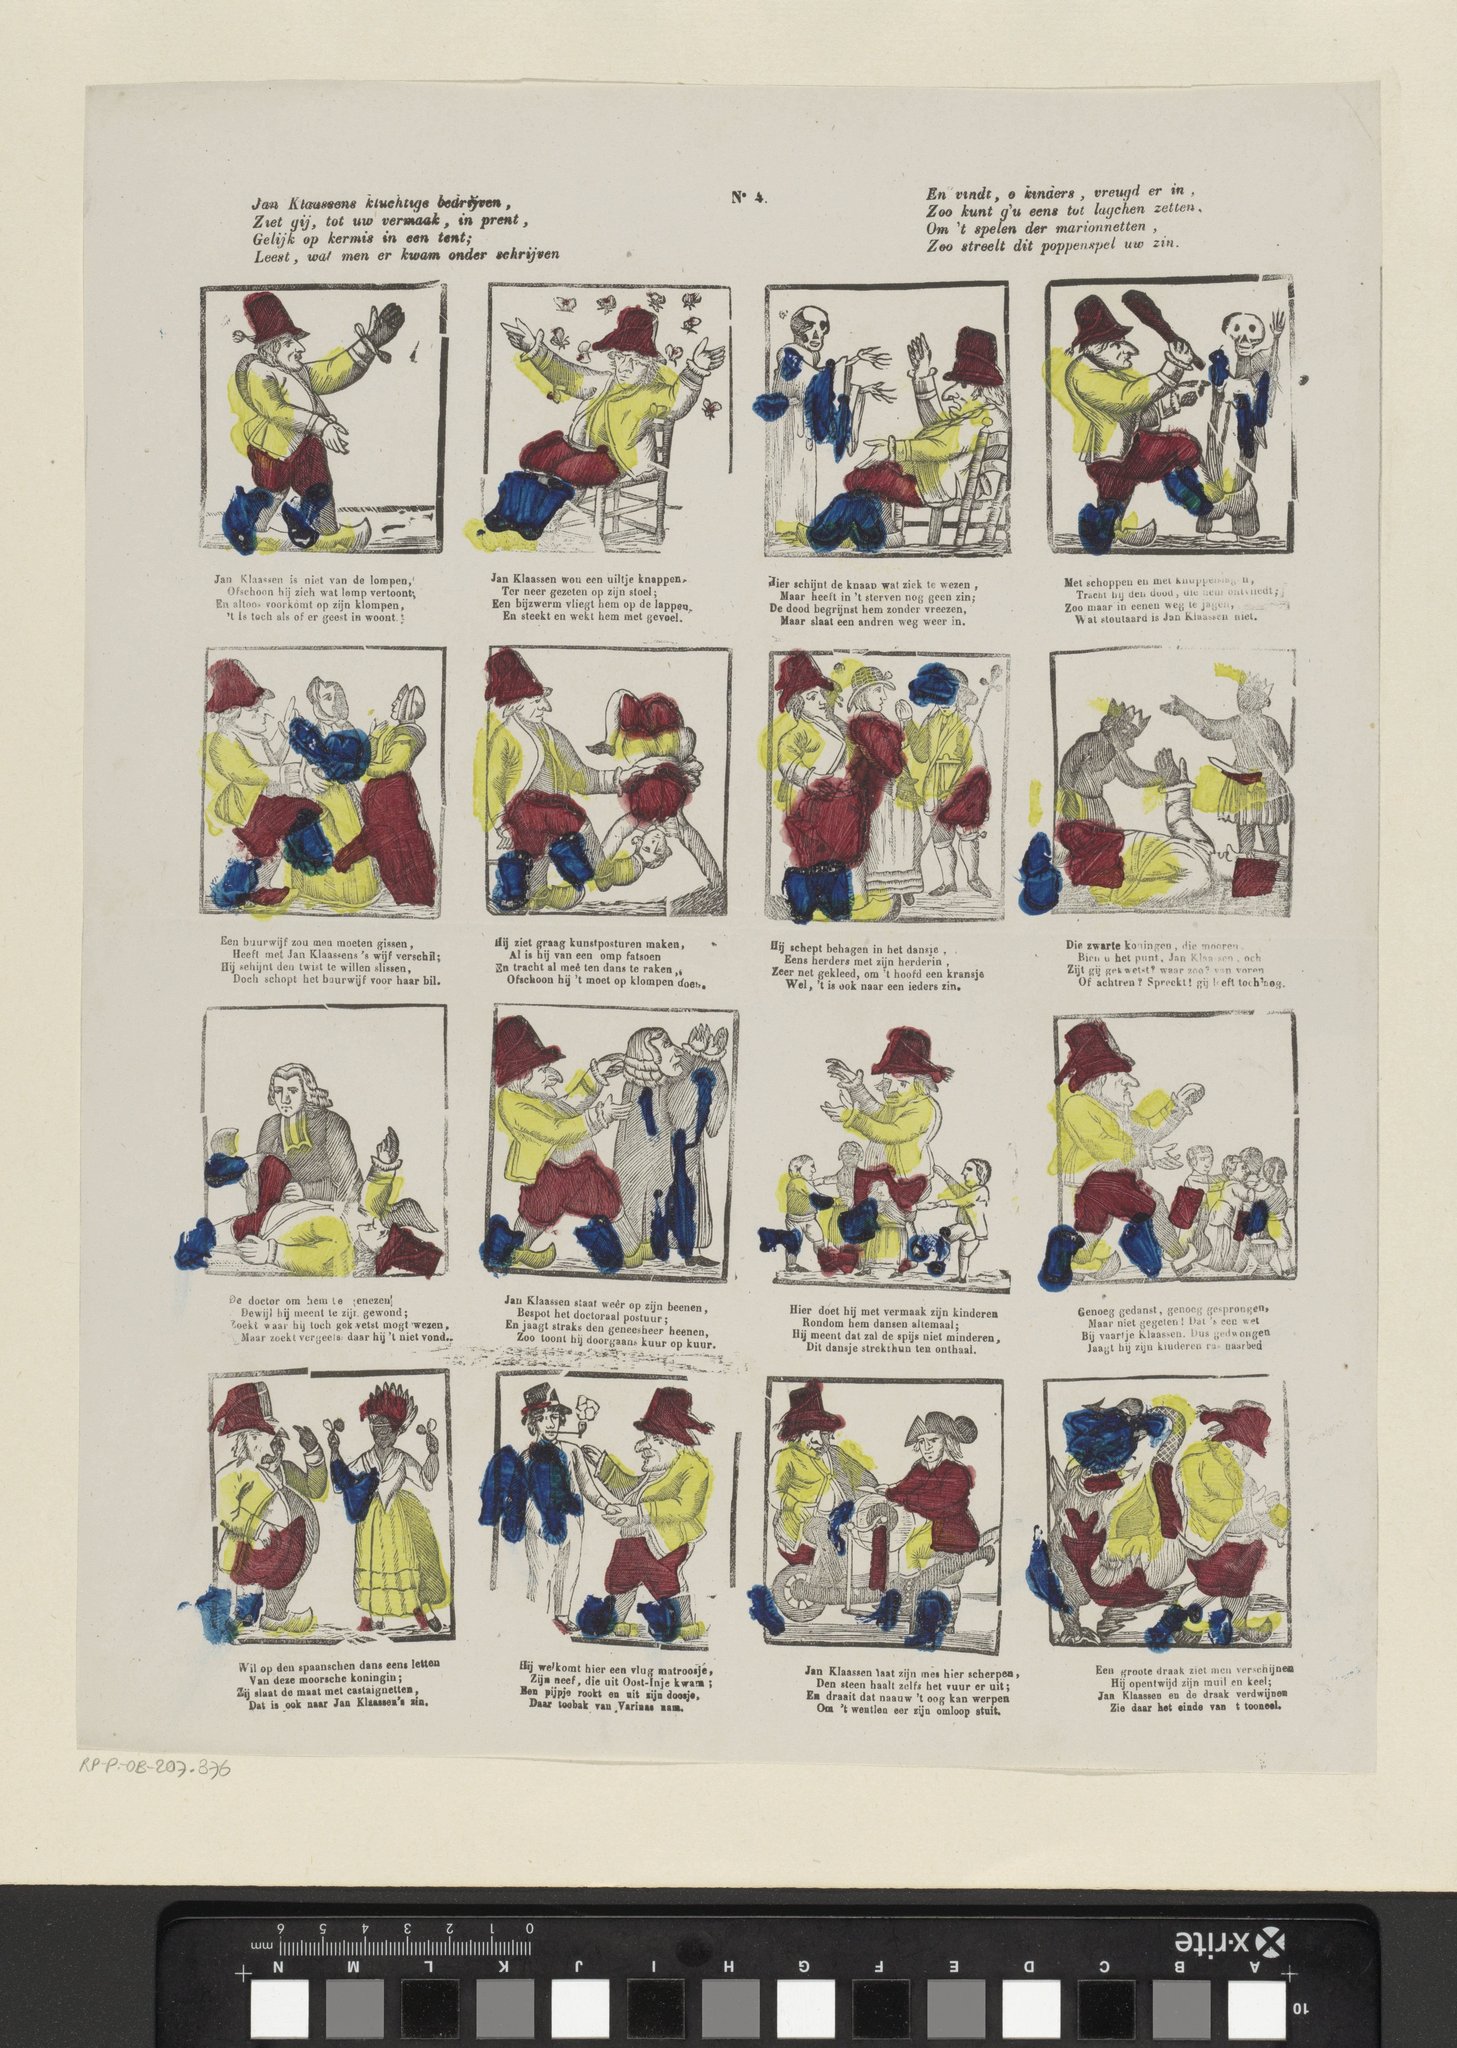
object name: print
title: Jan Klaassens kluchtige bedrijven, / Ziet gij, tot uw vermaak, in prent [(...)]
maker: Anonymous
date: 1848-1881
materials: paper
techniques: colour, letterpress printing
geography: den bosch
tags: punch and judy, tales and fairy tales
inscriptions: collector's mark: Lugt 2760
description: Blad met 16 voorstellingen over het leven van Jan Klaassen. Onder elke afbeelding een vierregelig vers. Genummerd midden boven: No 4.